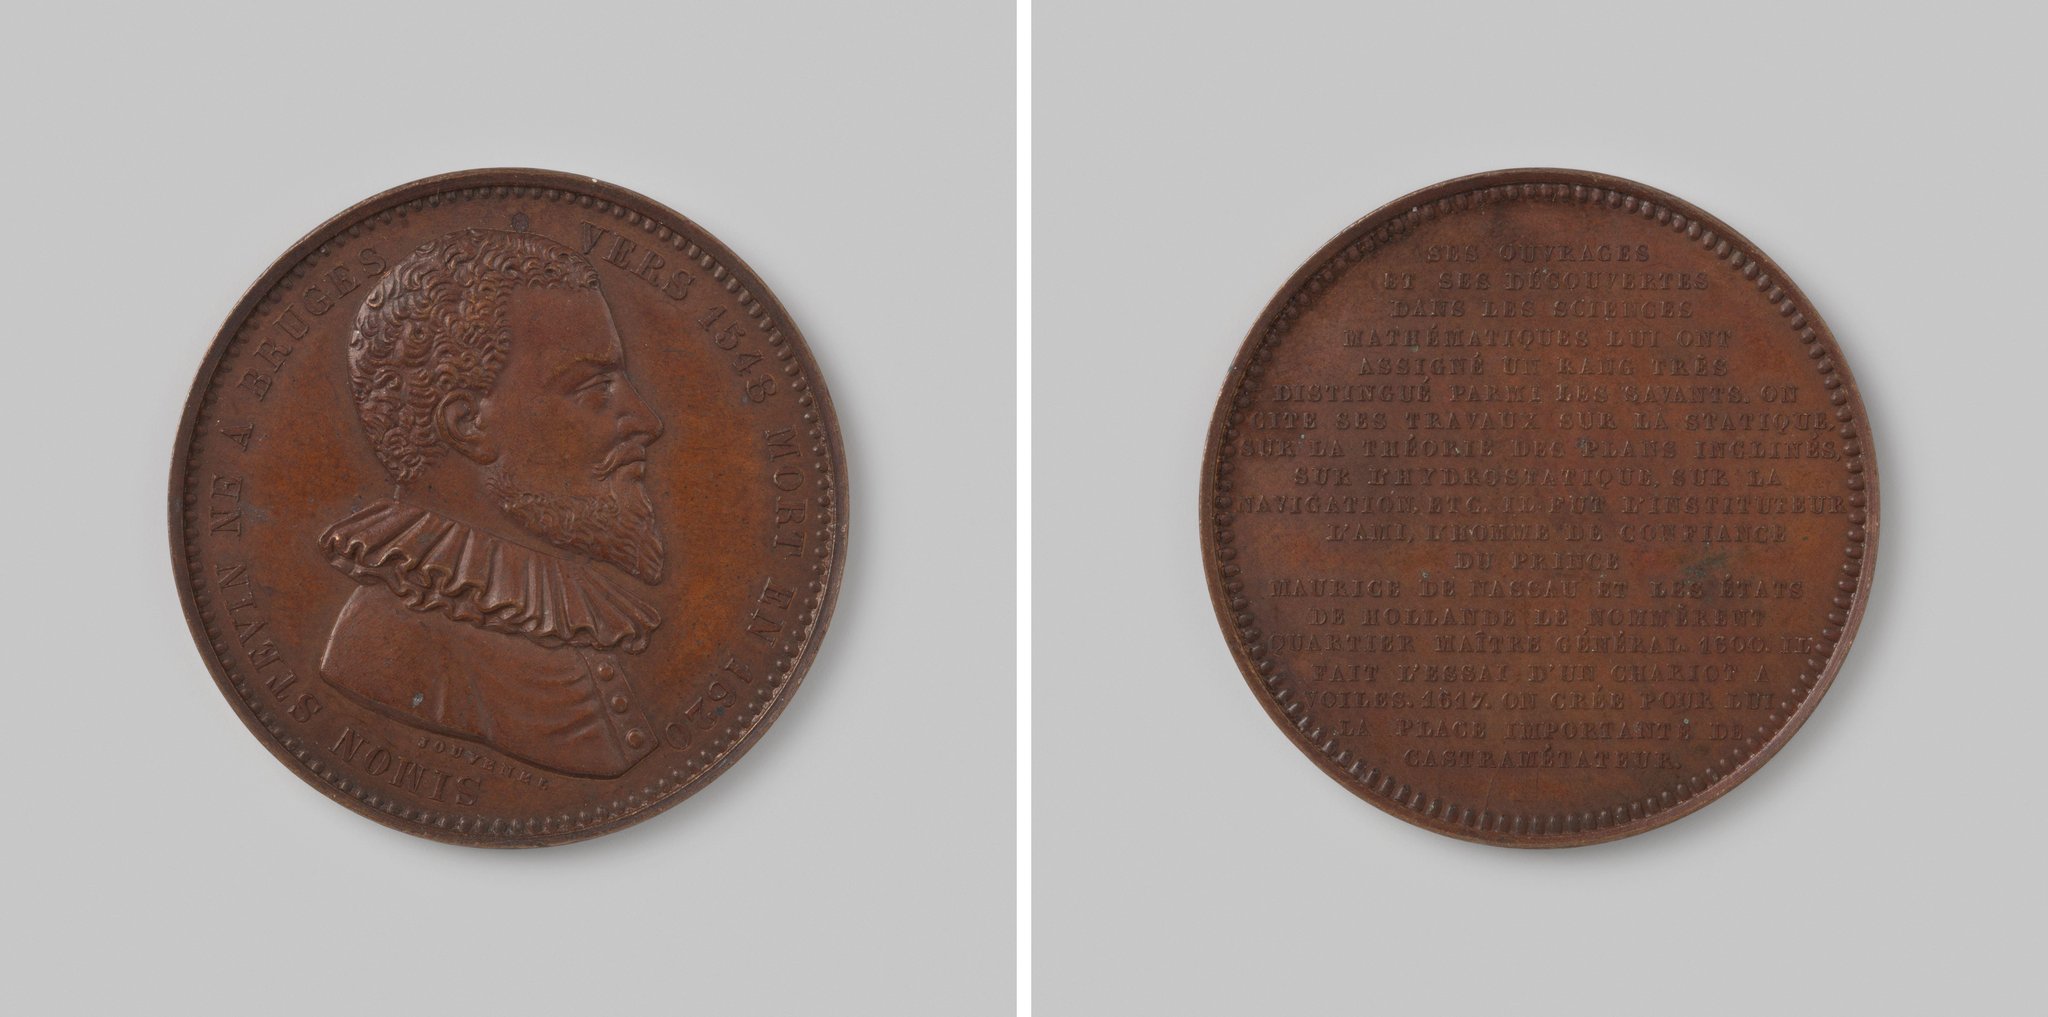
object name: history medal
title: Simon Stevin 1548-1620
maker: adolphe jouvenel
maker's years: 1798-1867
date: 1830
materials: bronze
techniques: striking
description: Bronzen penning, op de voorzijde het borstbeeld van Stevin naar rechts met omschrift, op de keerzijde negentien regels tekst.